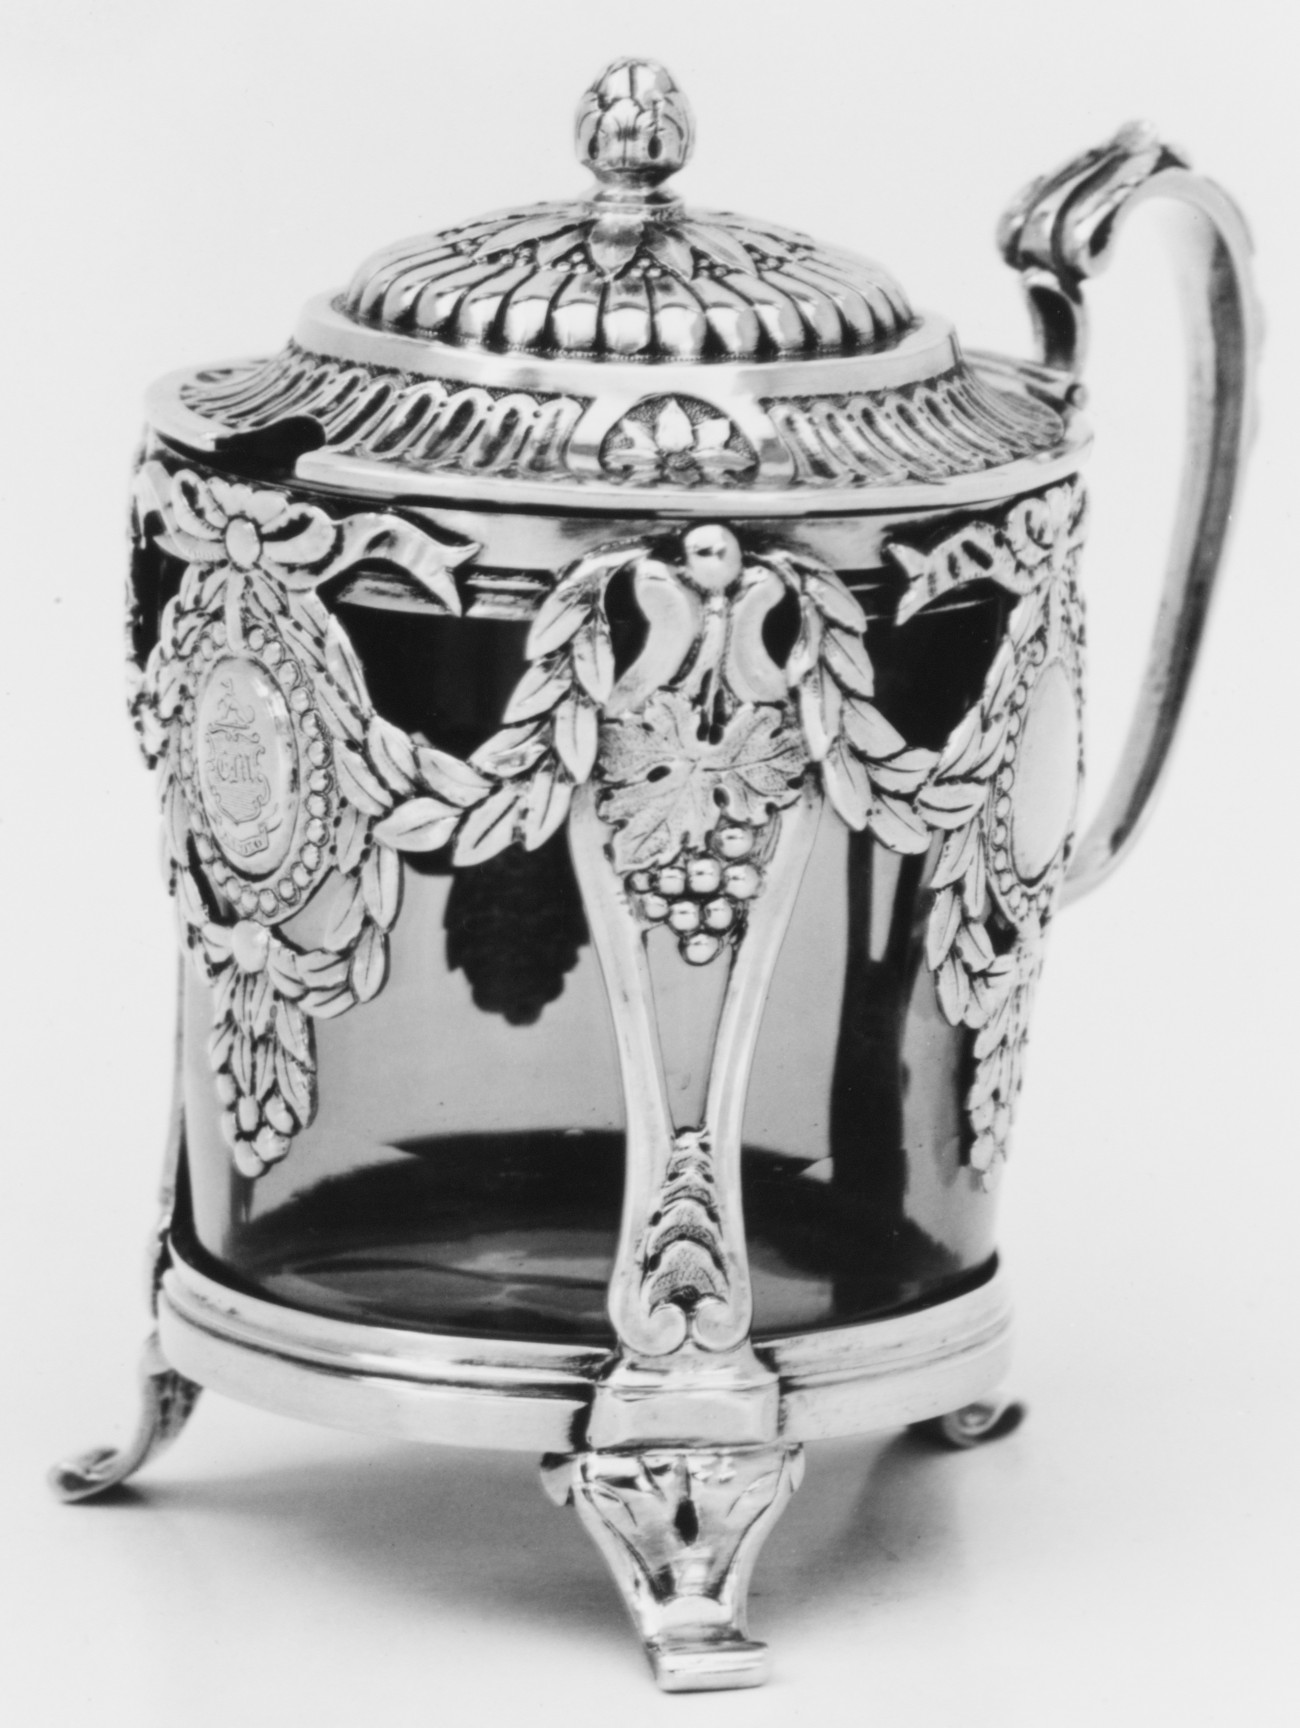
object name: mustard pot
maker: jean-baptiste saurin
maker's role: maker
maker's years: 1734-1834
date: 1778-1779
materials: glass, silver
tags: grapes